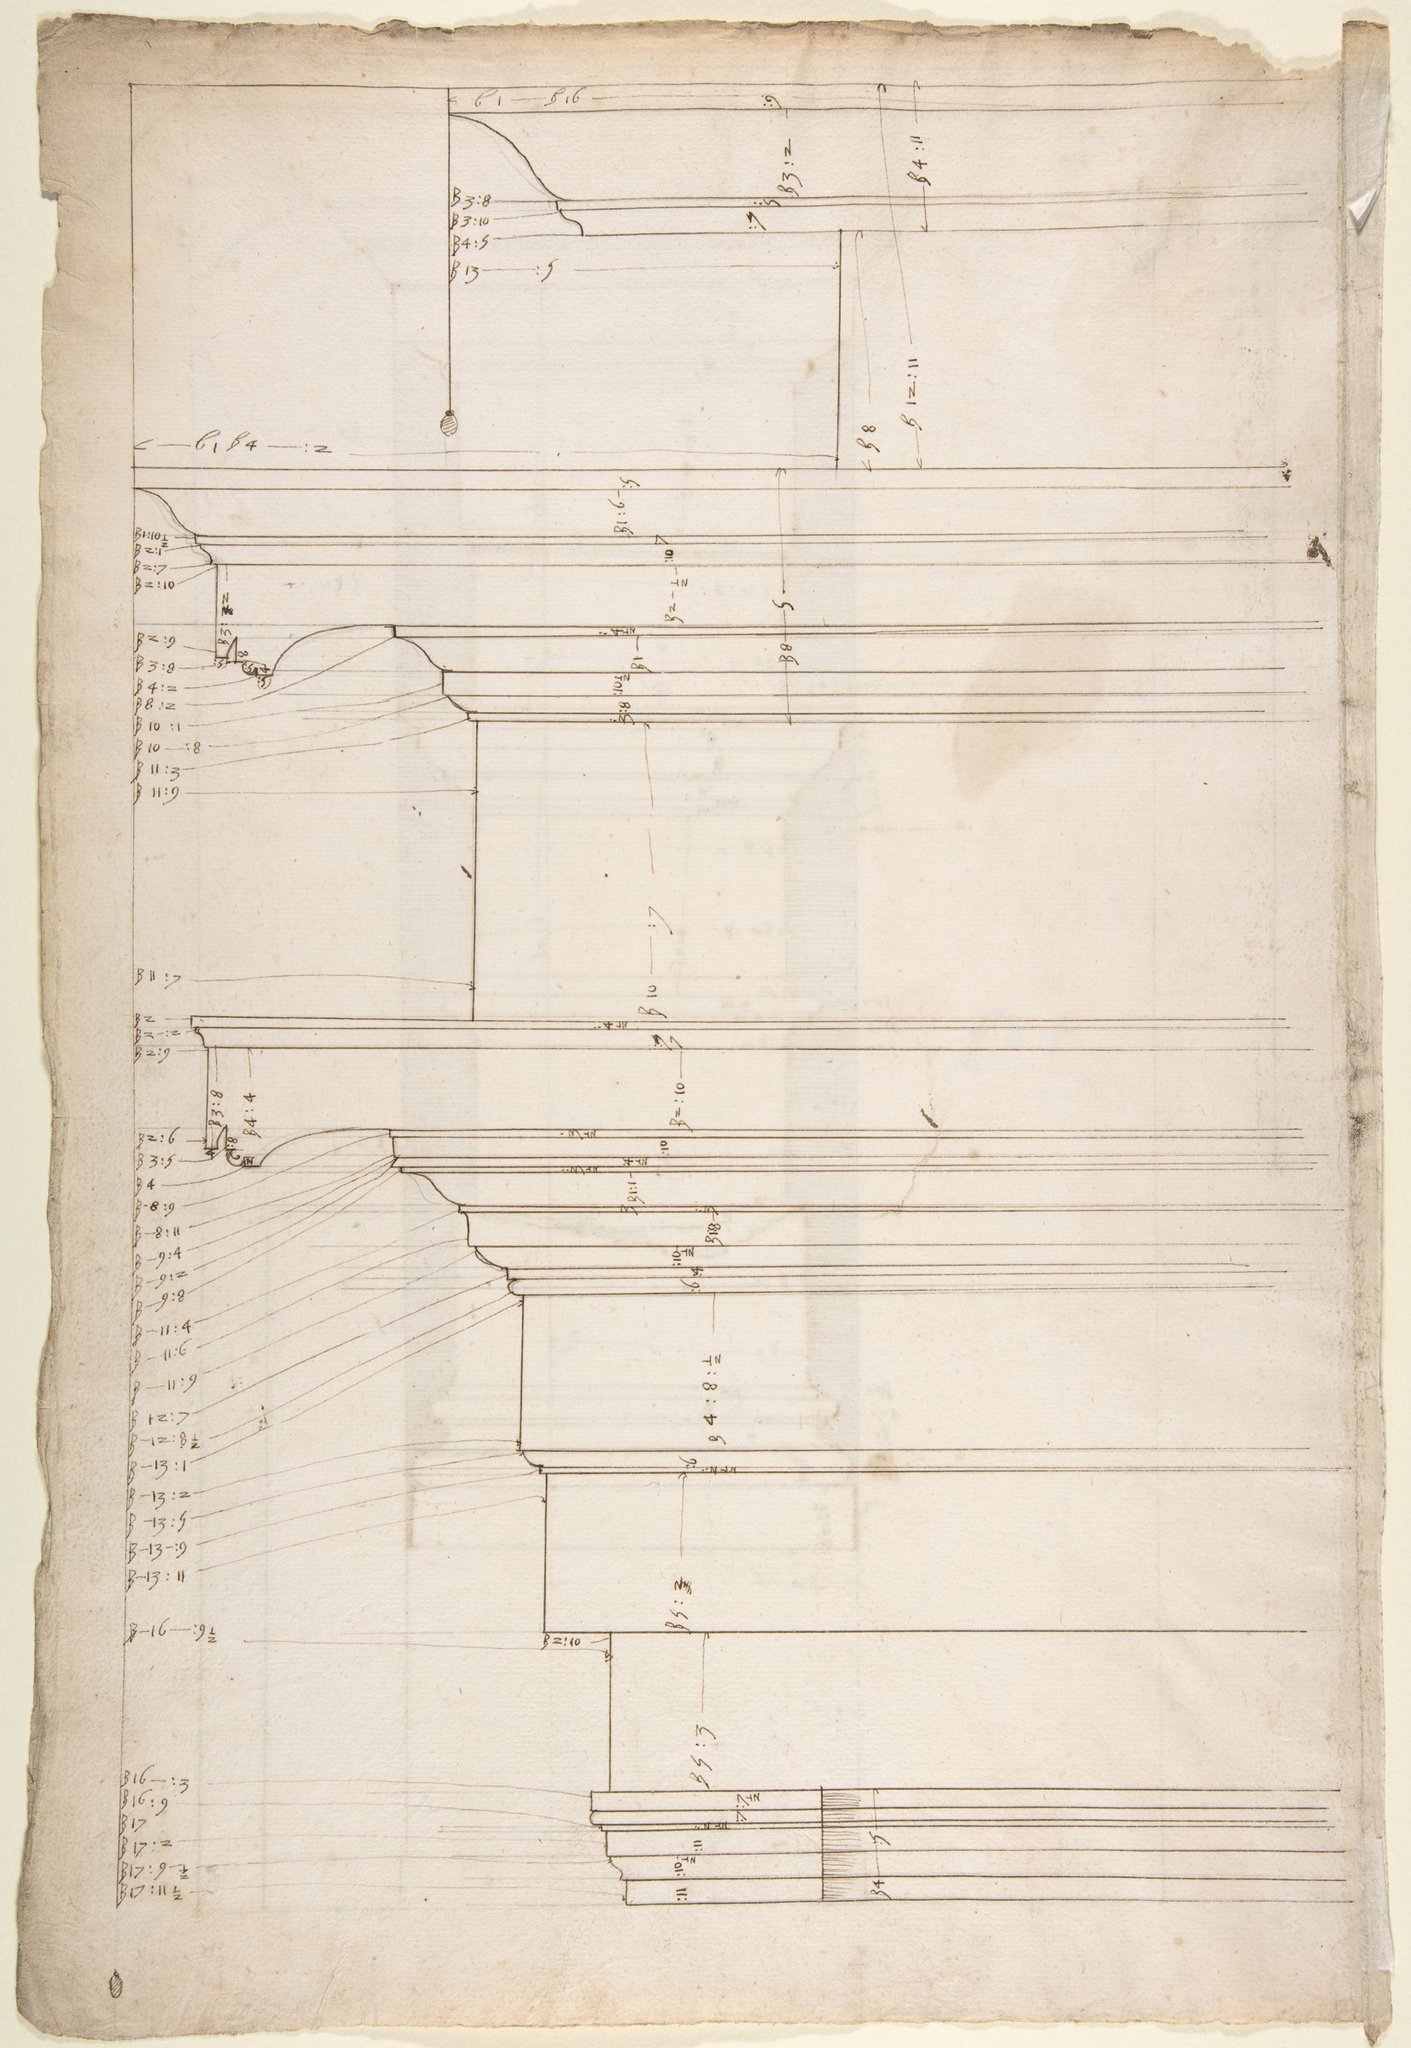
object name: drawing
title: San Lorenzo, Library, Ricetto, entablature, elevation profile (recto) San Lorenzo, Library, Ricetto, column, elevation (verso)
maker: anonymous, french, 16th century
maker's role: draftsman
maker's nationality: french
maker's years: 1500-1600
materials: chalk, ink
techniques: incising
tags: architecture